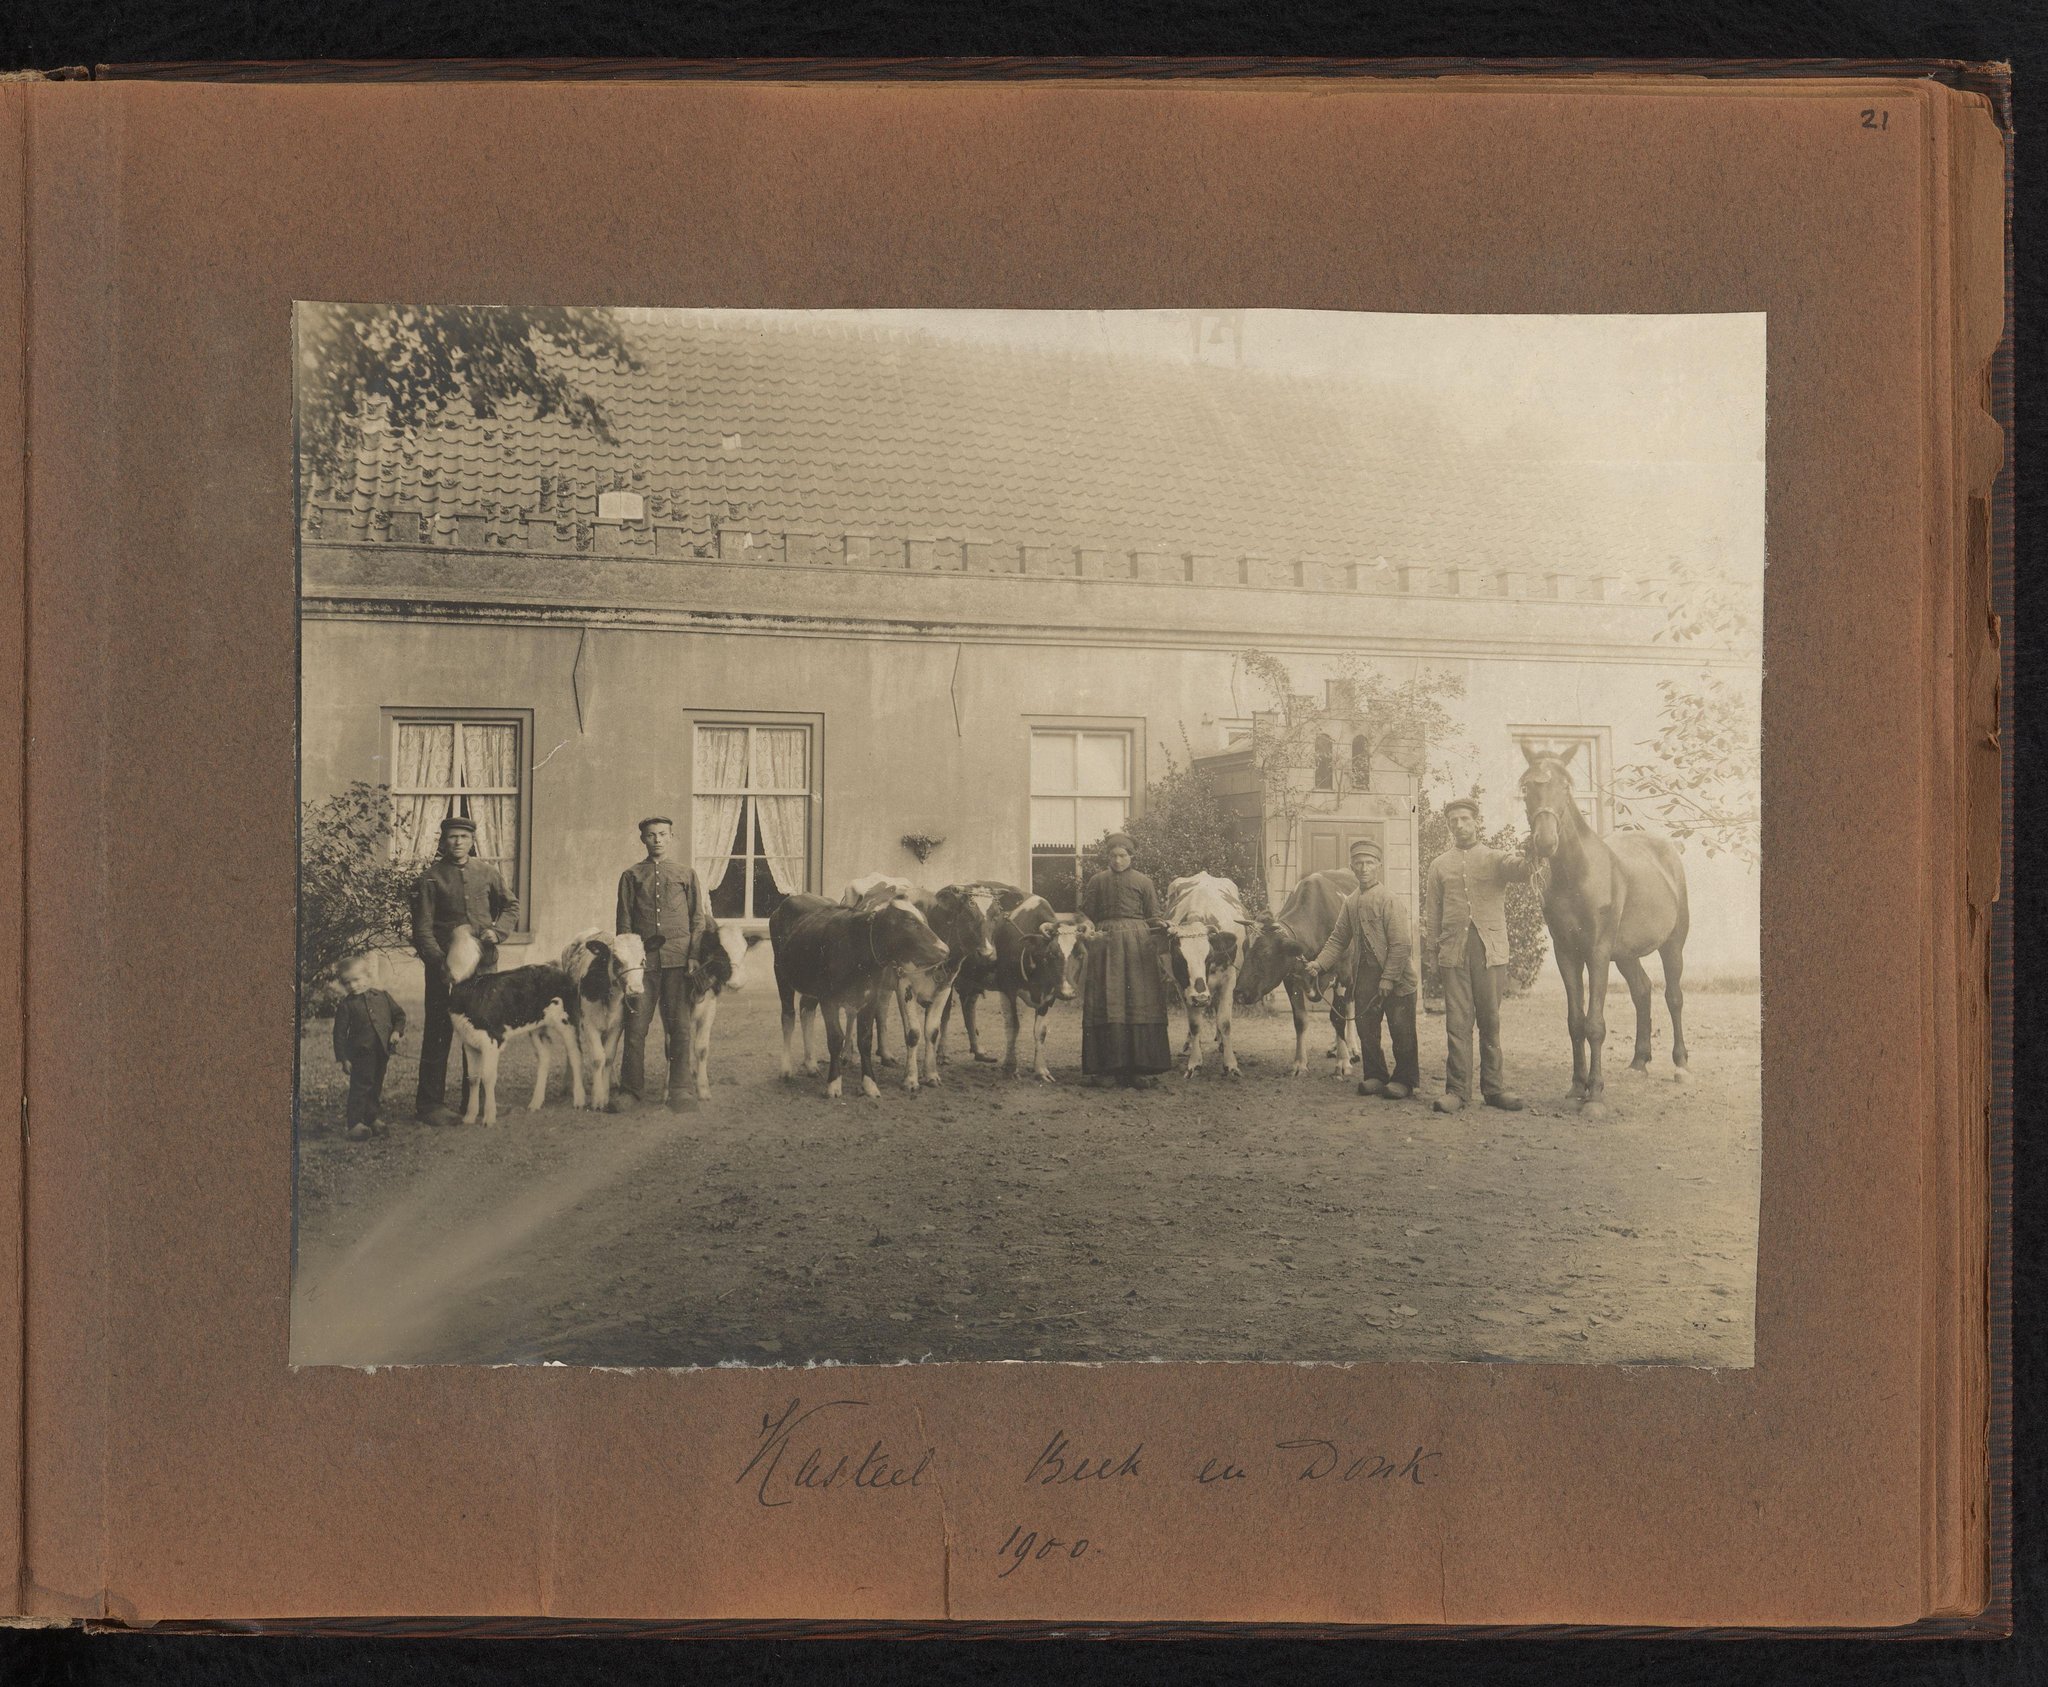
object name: photograph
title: Bladzijde uit het fotoalbum van de familie Diepenbrock met foto van arbeiders met vee op Kasteel Beek en Donk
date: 1900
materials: cardboard, photographic support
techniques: photography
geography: netherlands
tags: kasteel eikenlust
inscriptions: inscription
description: Bruin albumblad 21 van familiealbum van Alphons Diepenbrock.